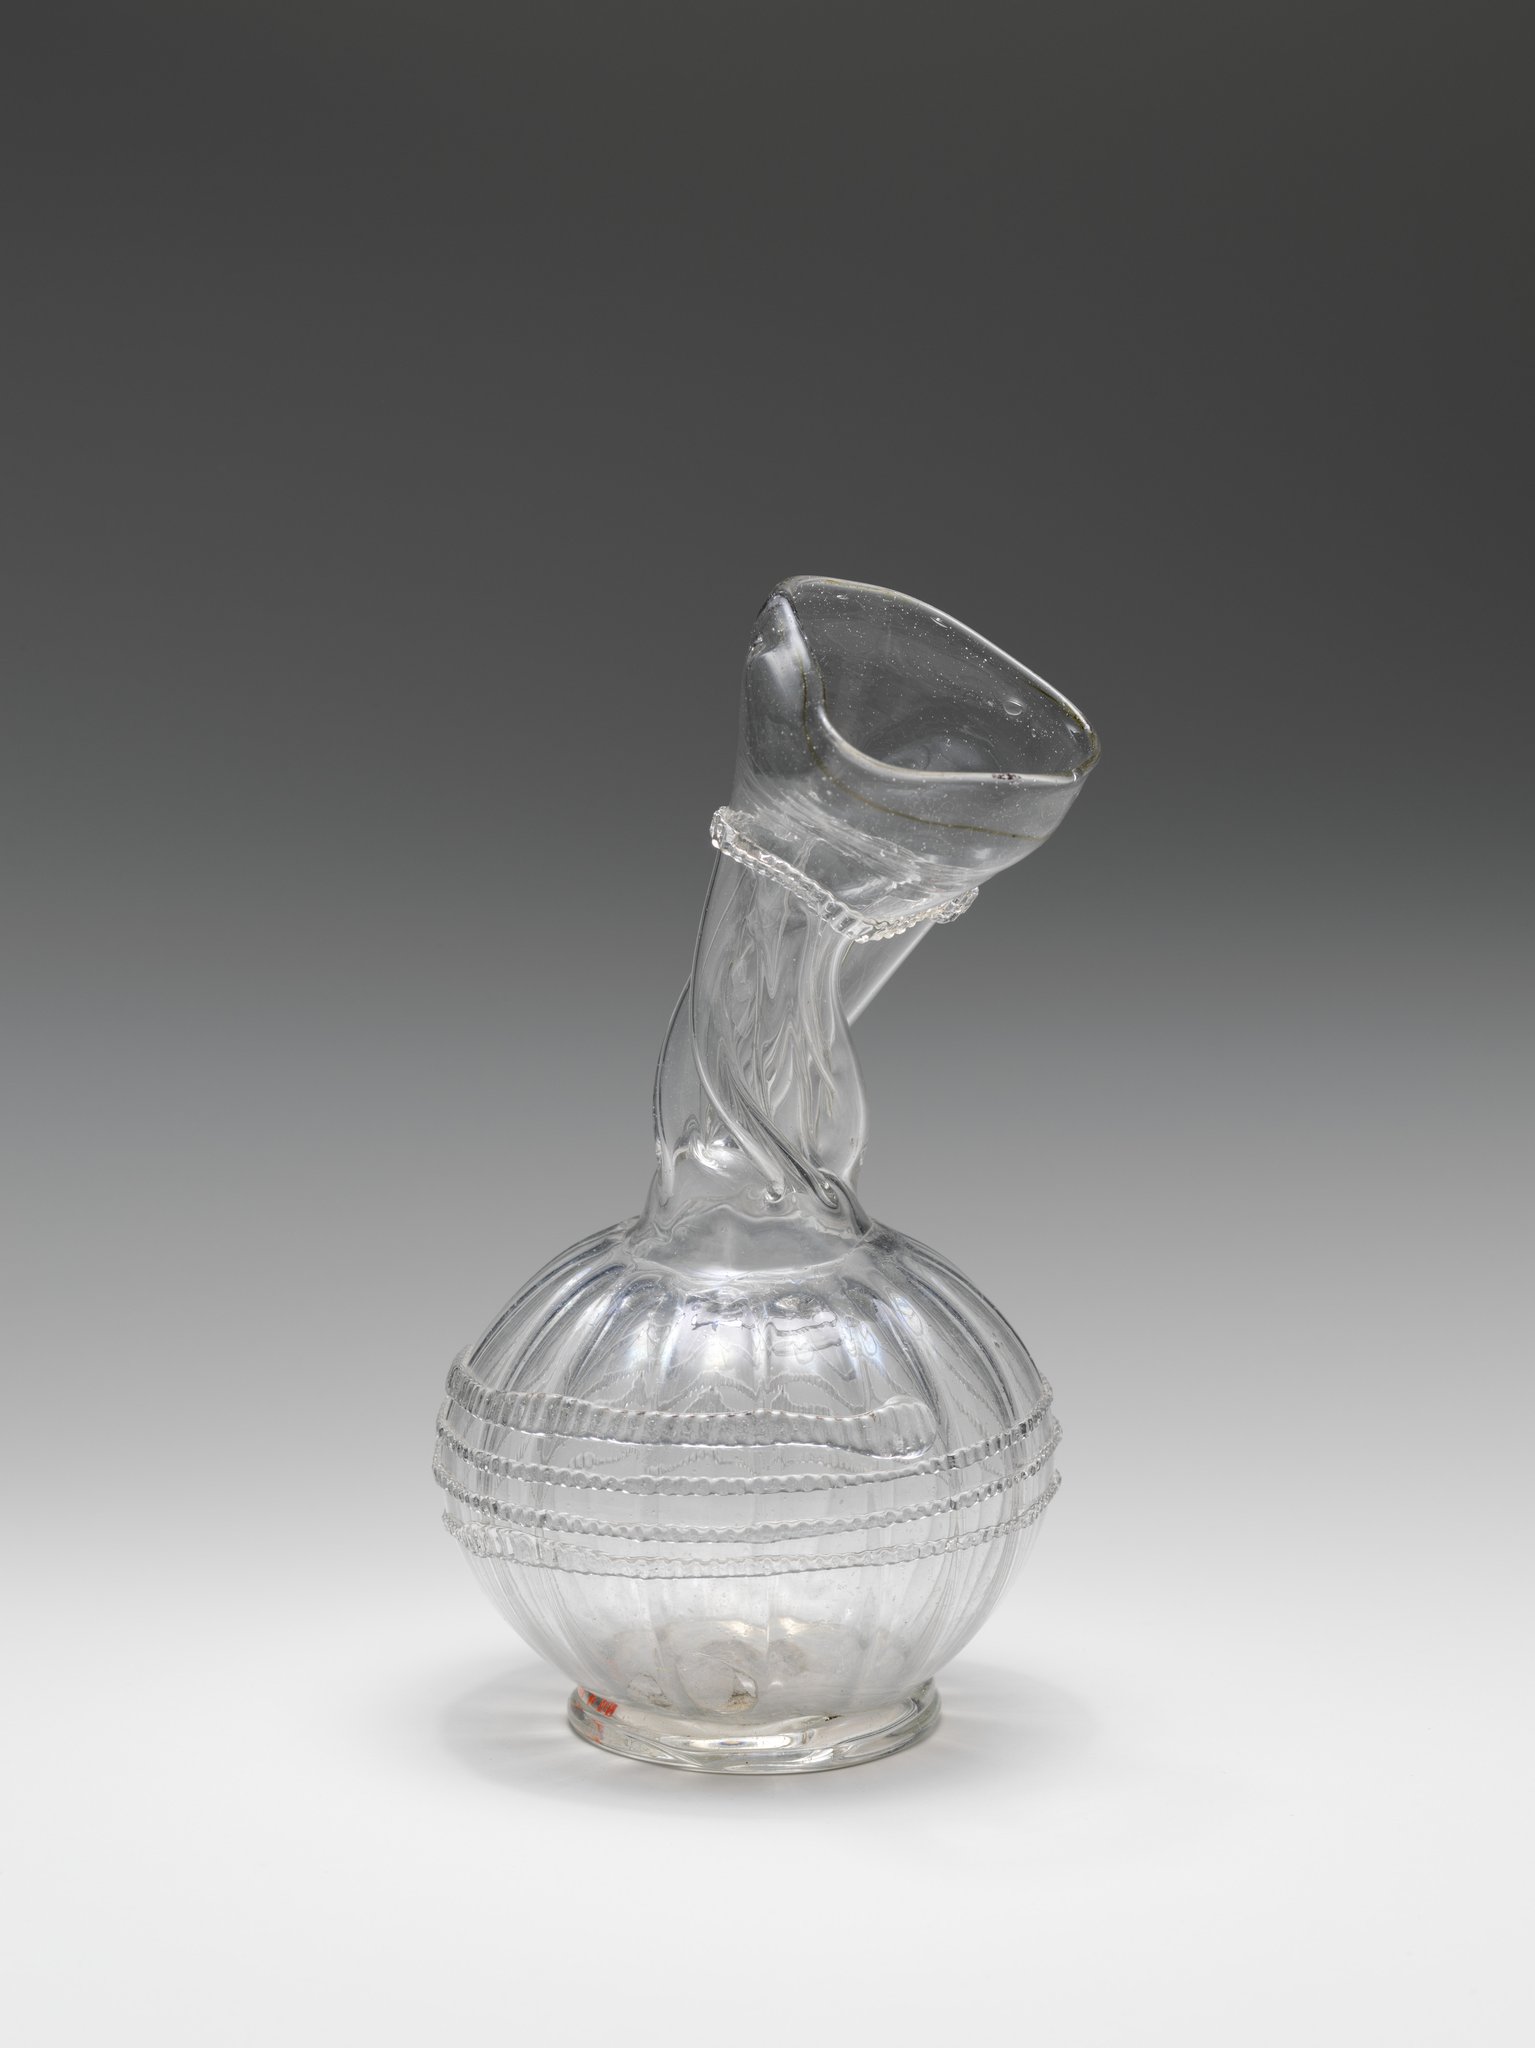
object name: bottle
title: Bottle (Kuttrolf)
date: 1601-1700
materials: glass